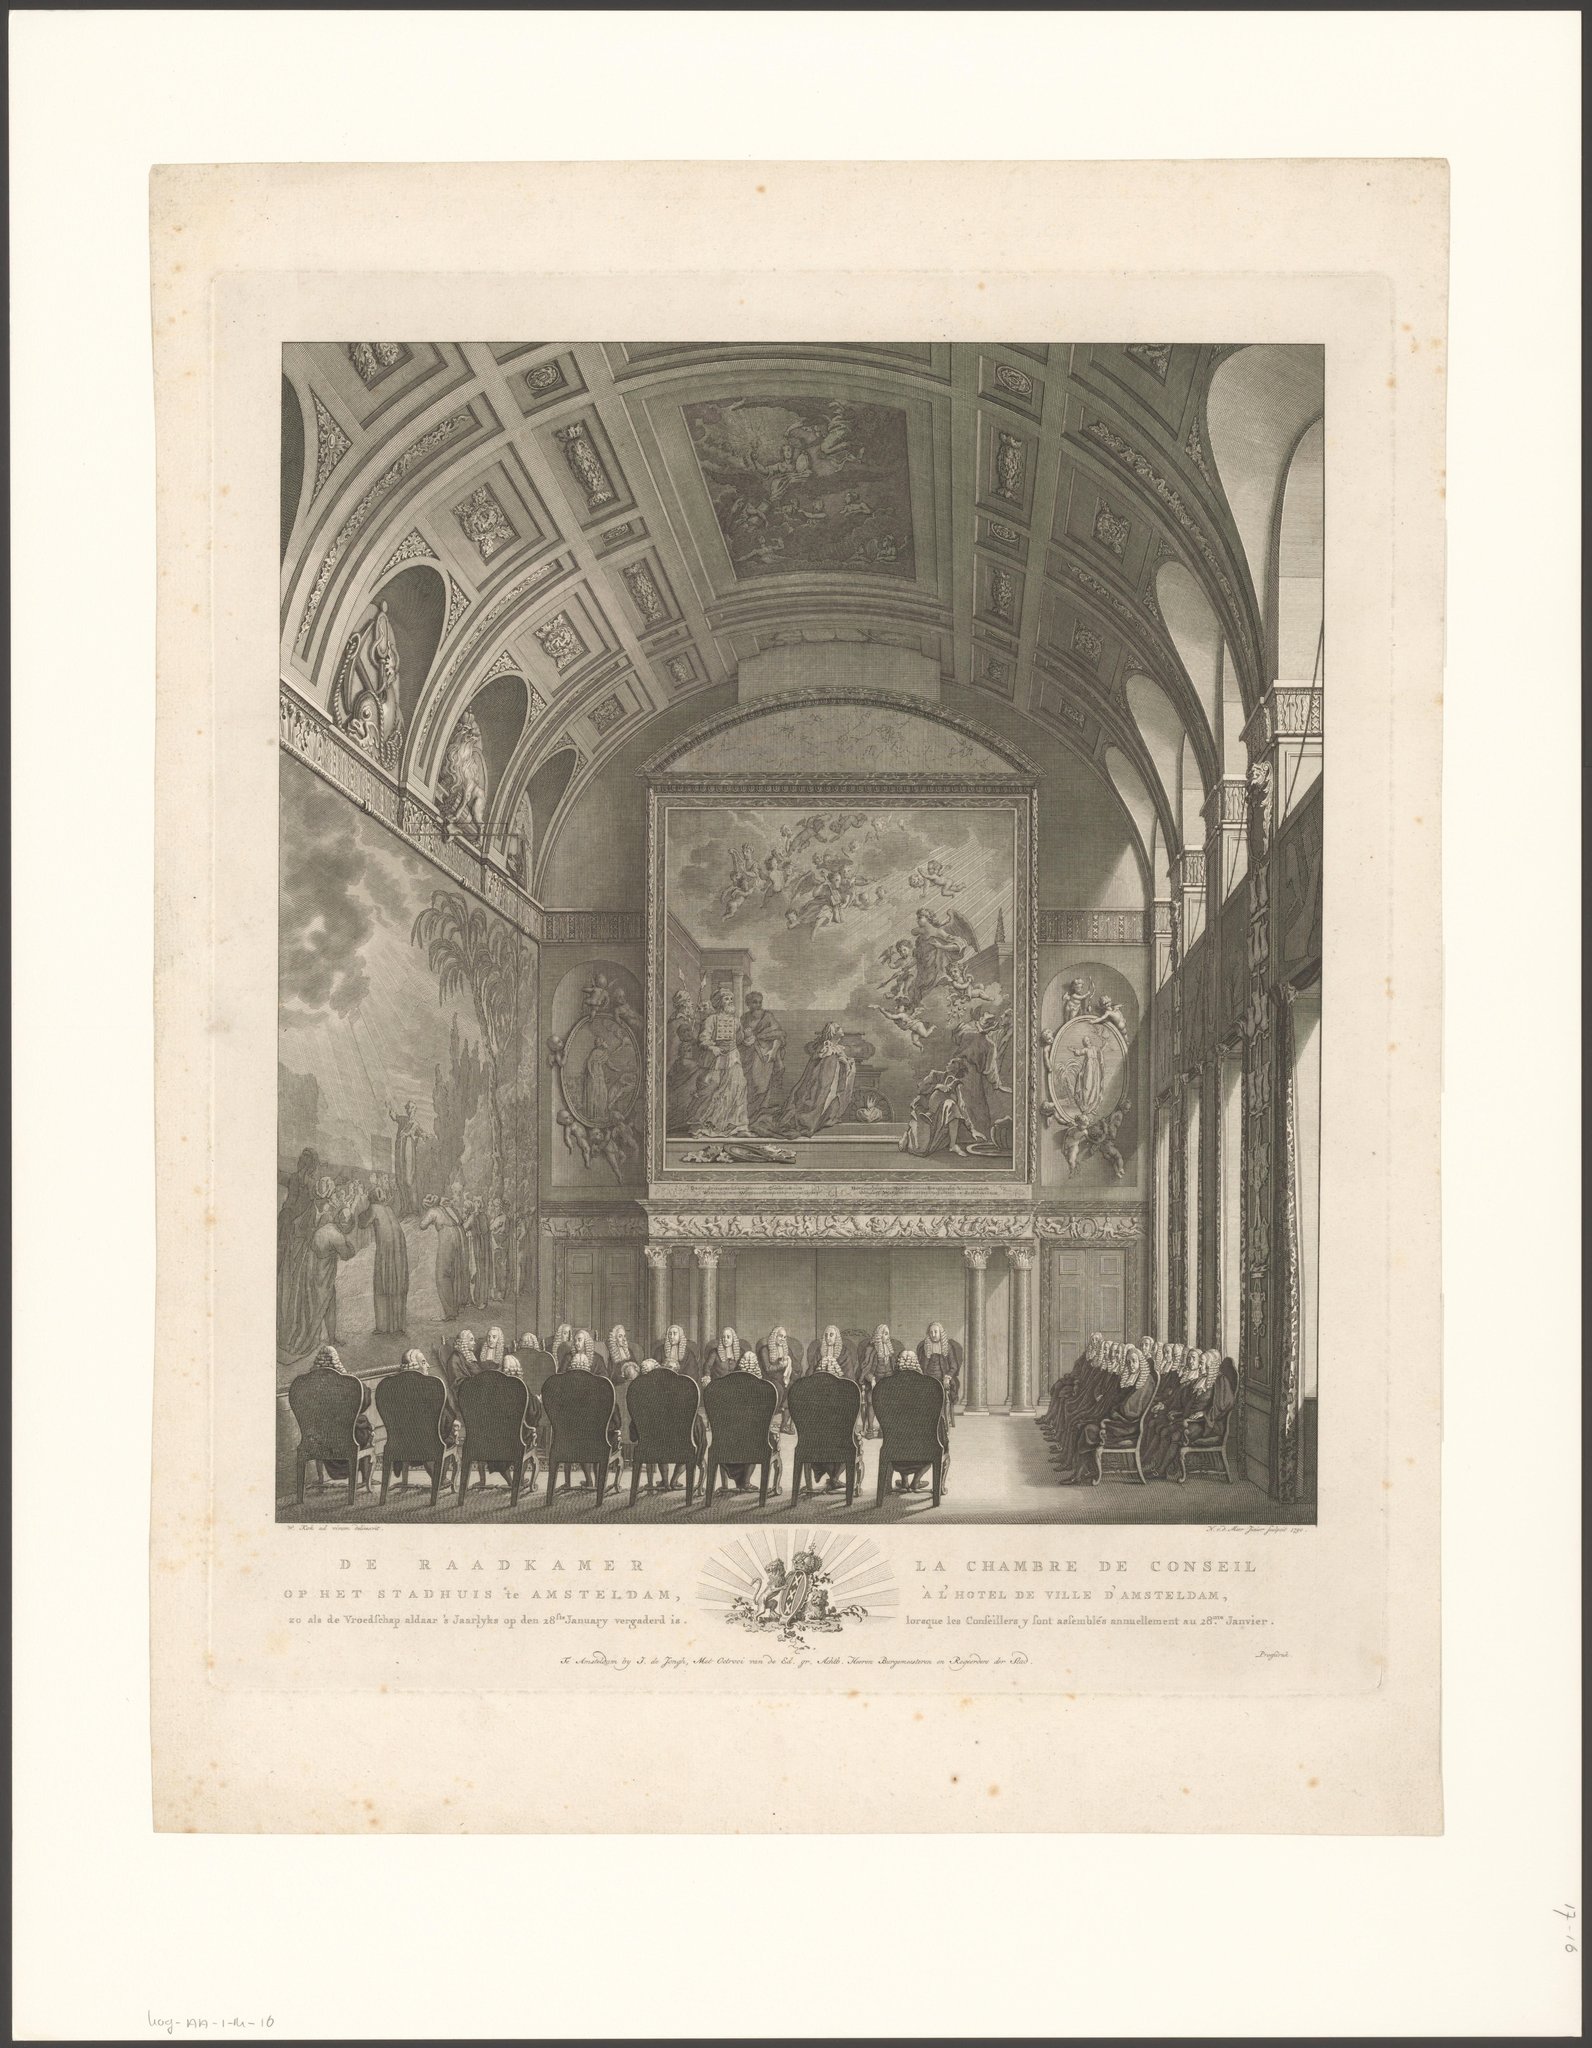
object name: print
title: De Raadkamer op het Stadhuis te Amsterdam, zo als de Vroedschap aldaar 's Jaarlyks op den 28ste January vergaderd is / La Chambre de Conseil à l'Hotel de Ville d'Amsteldam, lorsque les Conseillers y sont assemblés annuellement au 28me. Janvier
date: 1790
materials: paper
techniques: engraving, etching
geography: amsterdam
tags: city council, townhall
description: Onderwerpsrubriek binnen de Atlas Amsterdam: Nieuwe Stadhuis, van binnen: Groote zaal, Raadkamer, Schepenkamer, Troonzaal, Mozeszaal, Zitkamer.